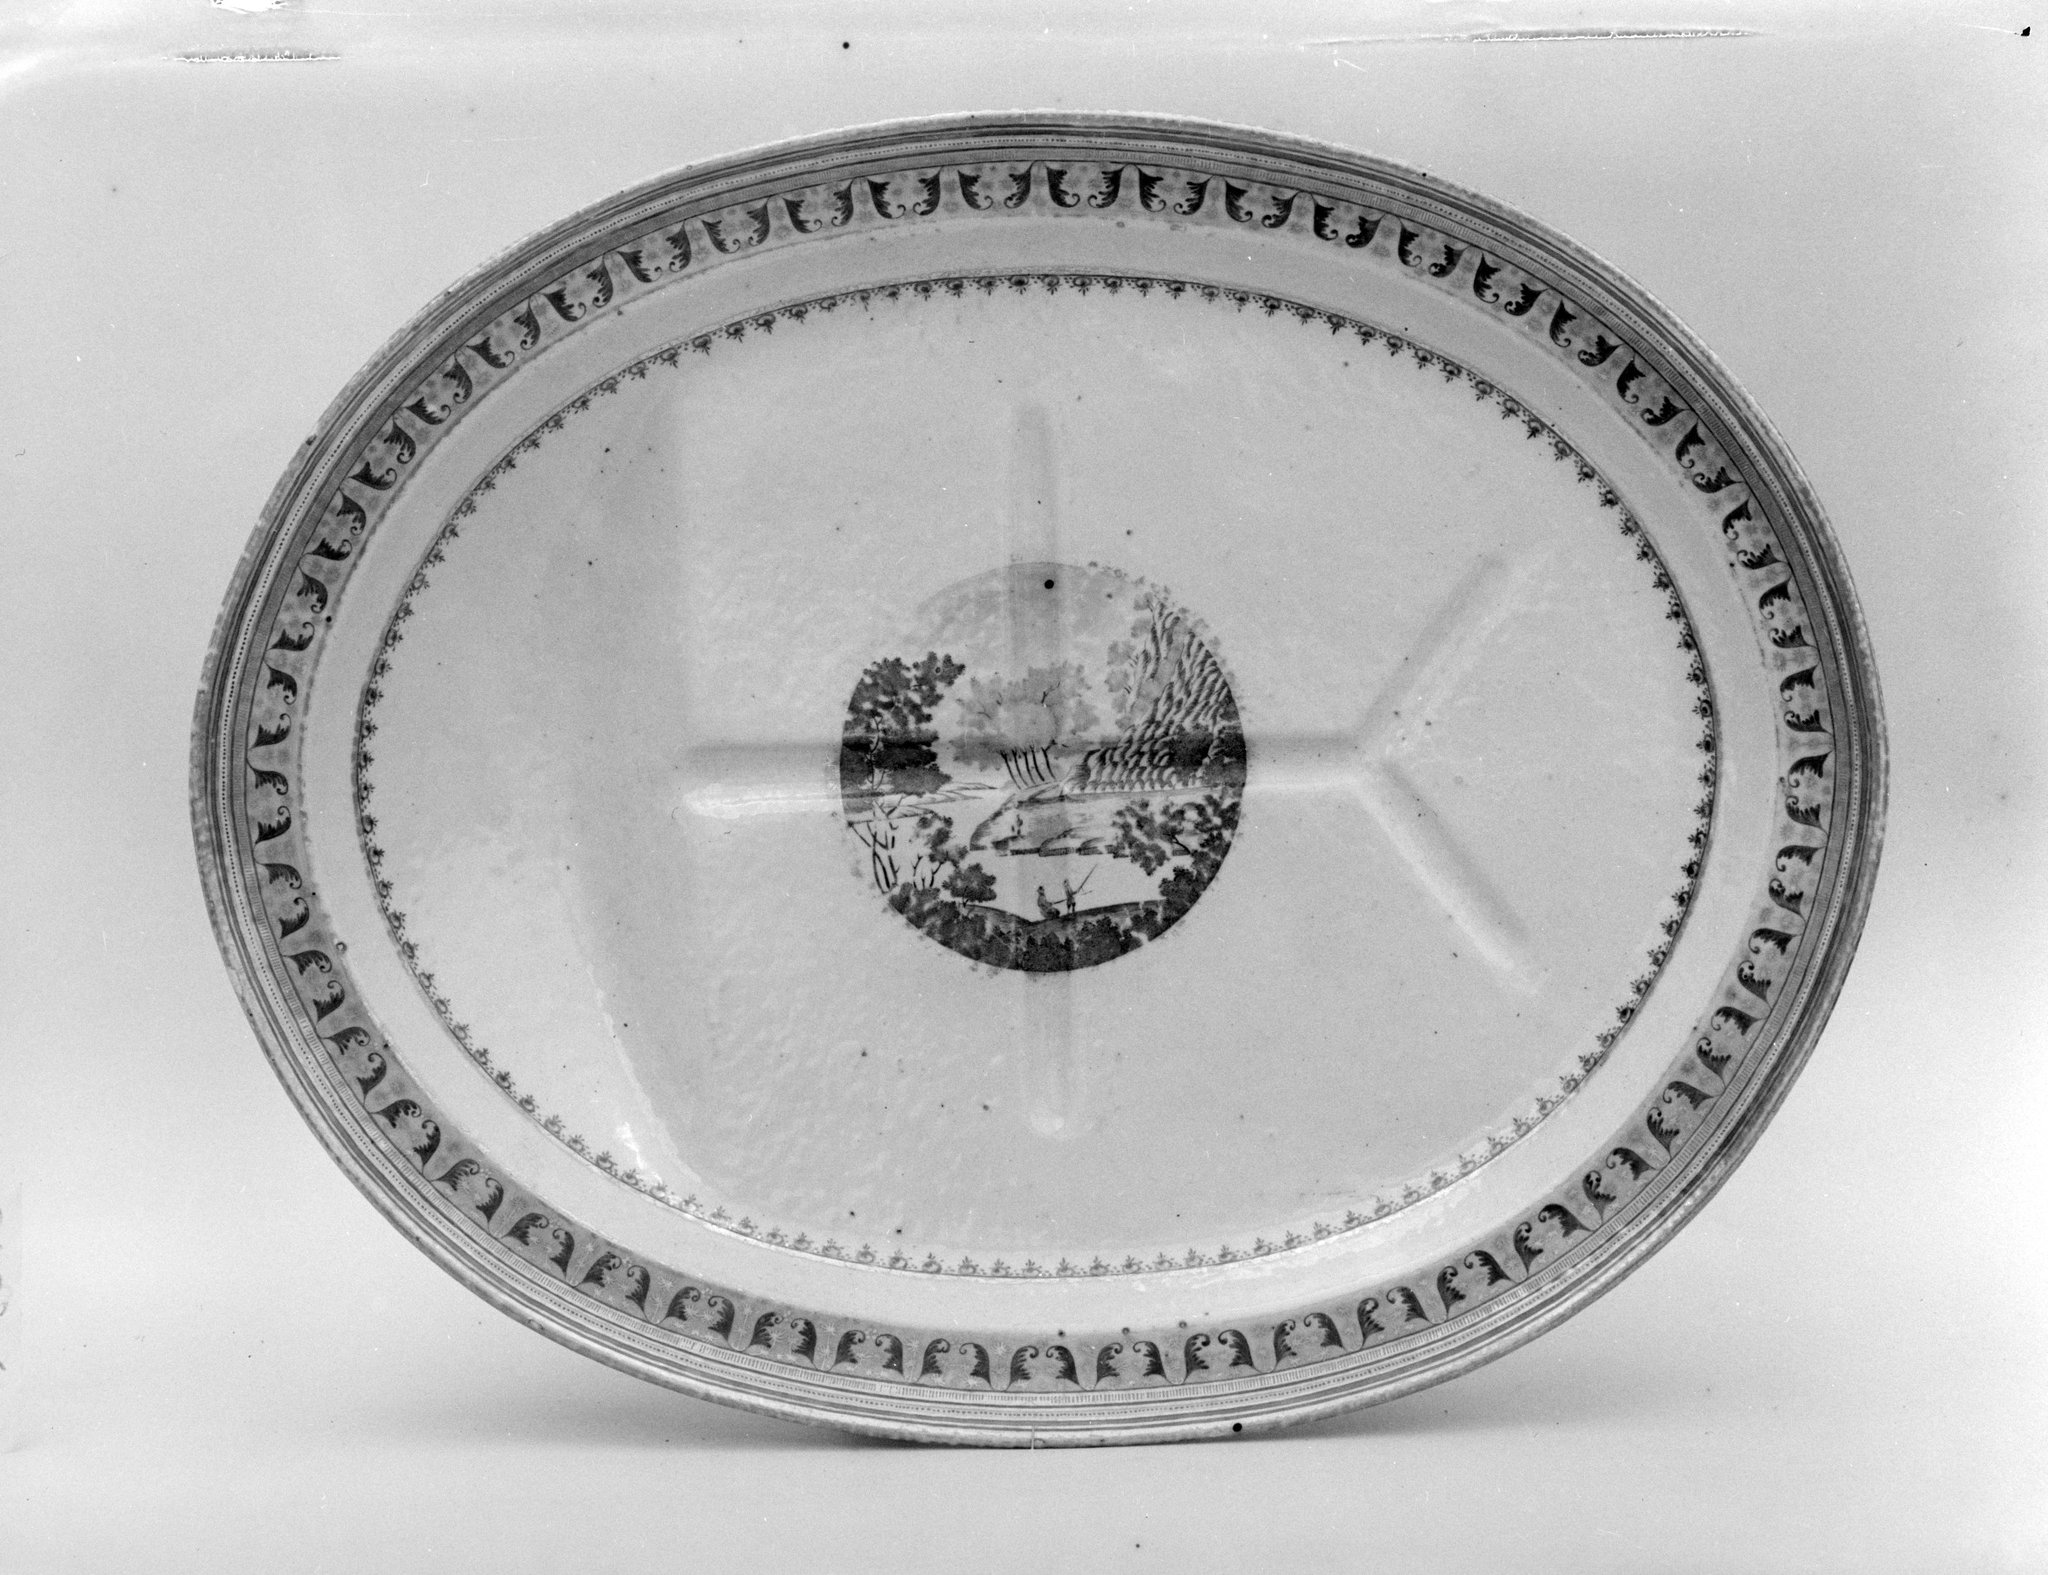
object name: meat platter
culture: chinese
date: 1800-1830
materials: porcelain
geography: china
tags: landscapes